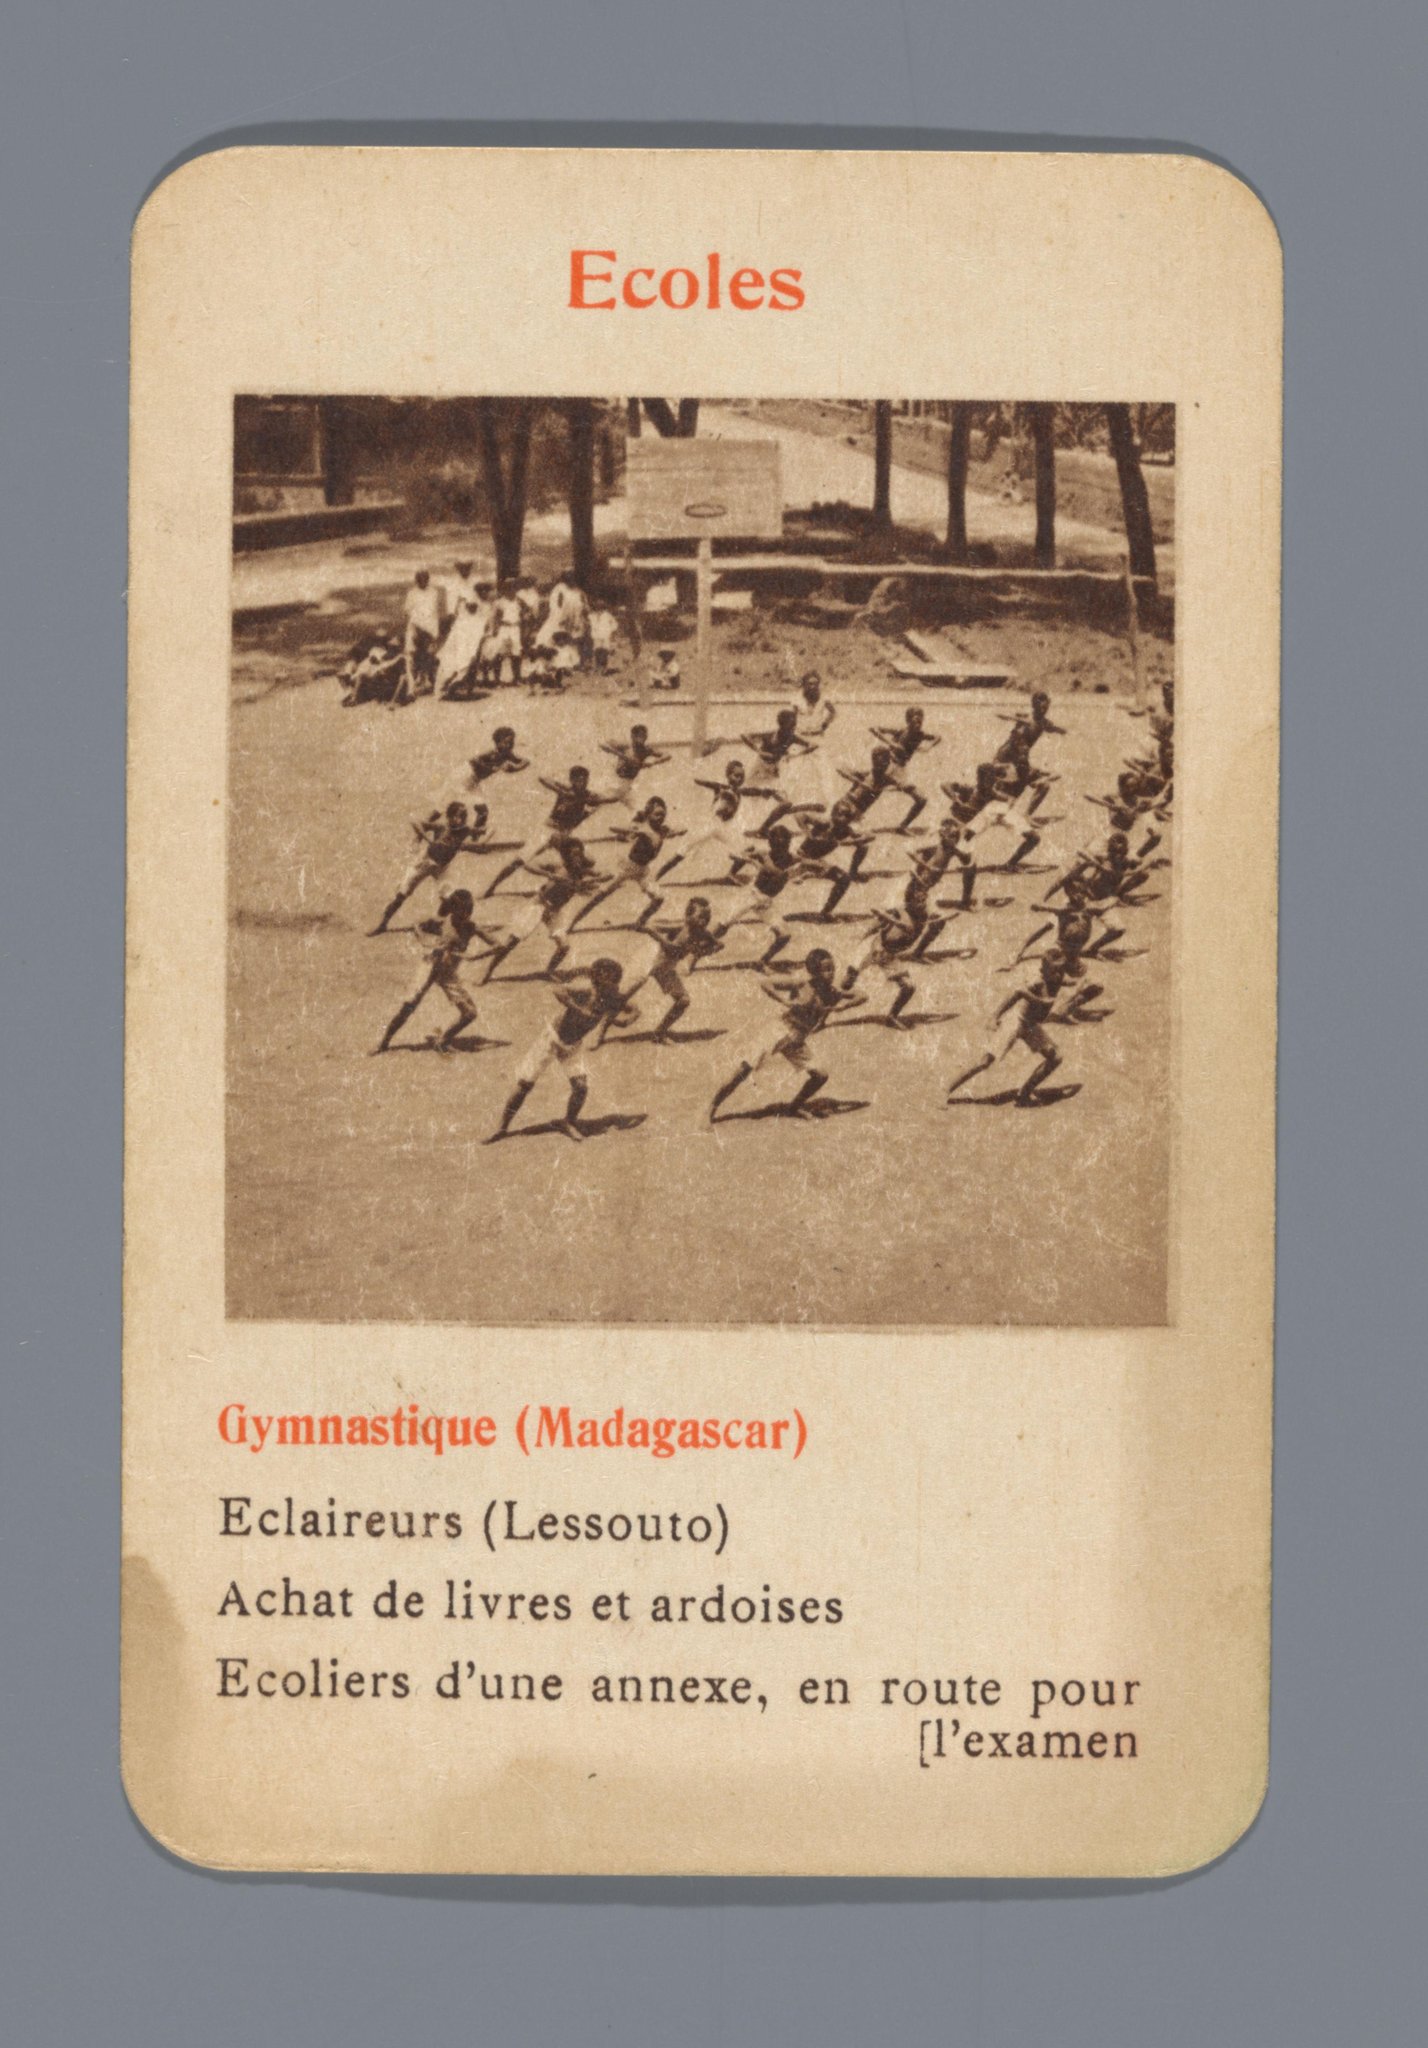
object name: card game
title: Jongens tijdens de gymnastiekles in Madagaskar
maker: Anonymous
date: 1900-1920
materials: cardboard, paper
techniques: rotogravure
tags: going to school, gymnastic exercises on the ground, card games